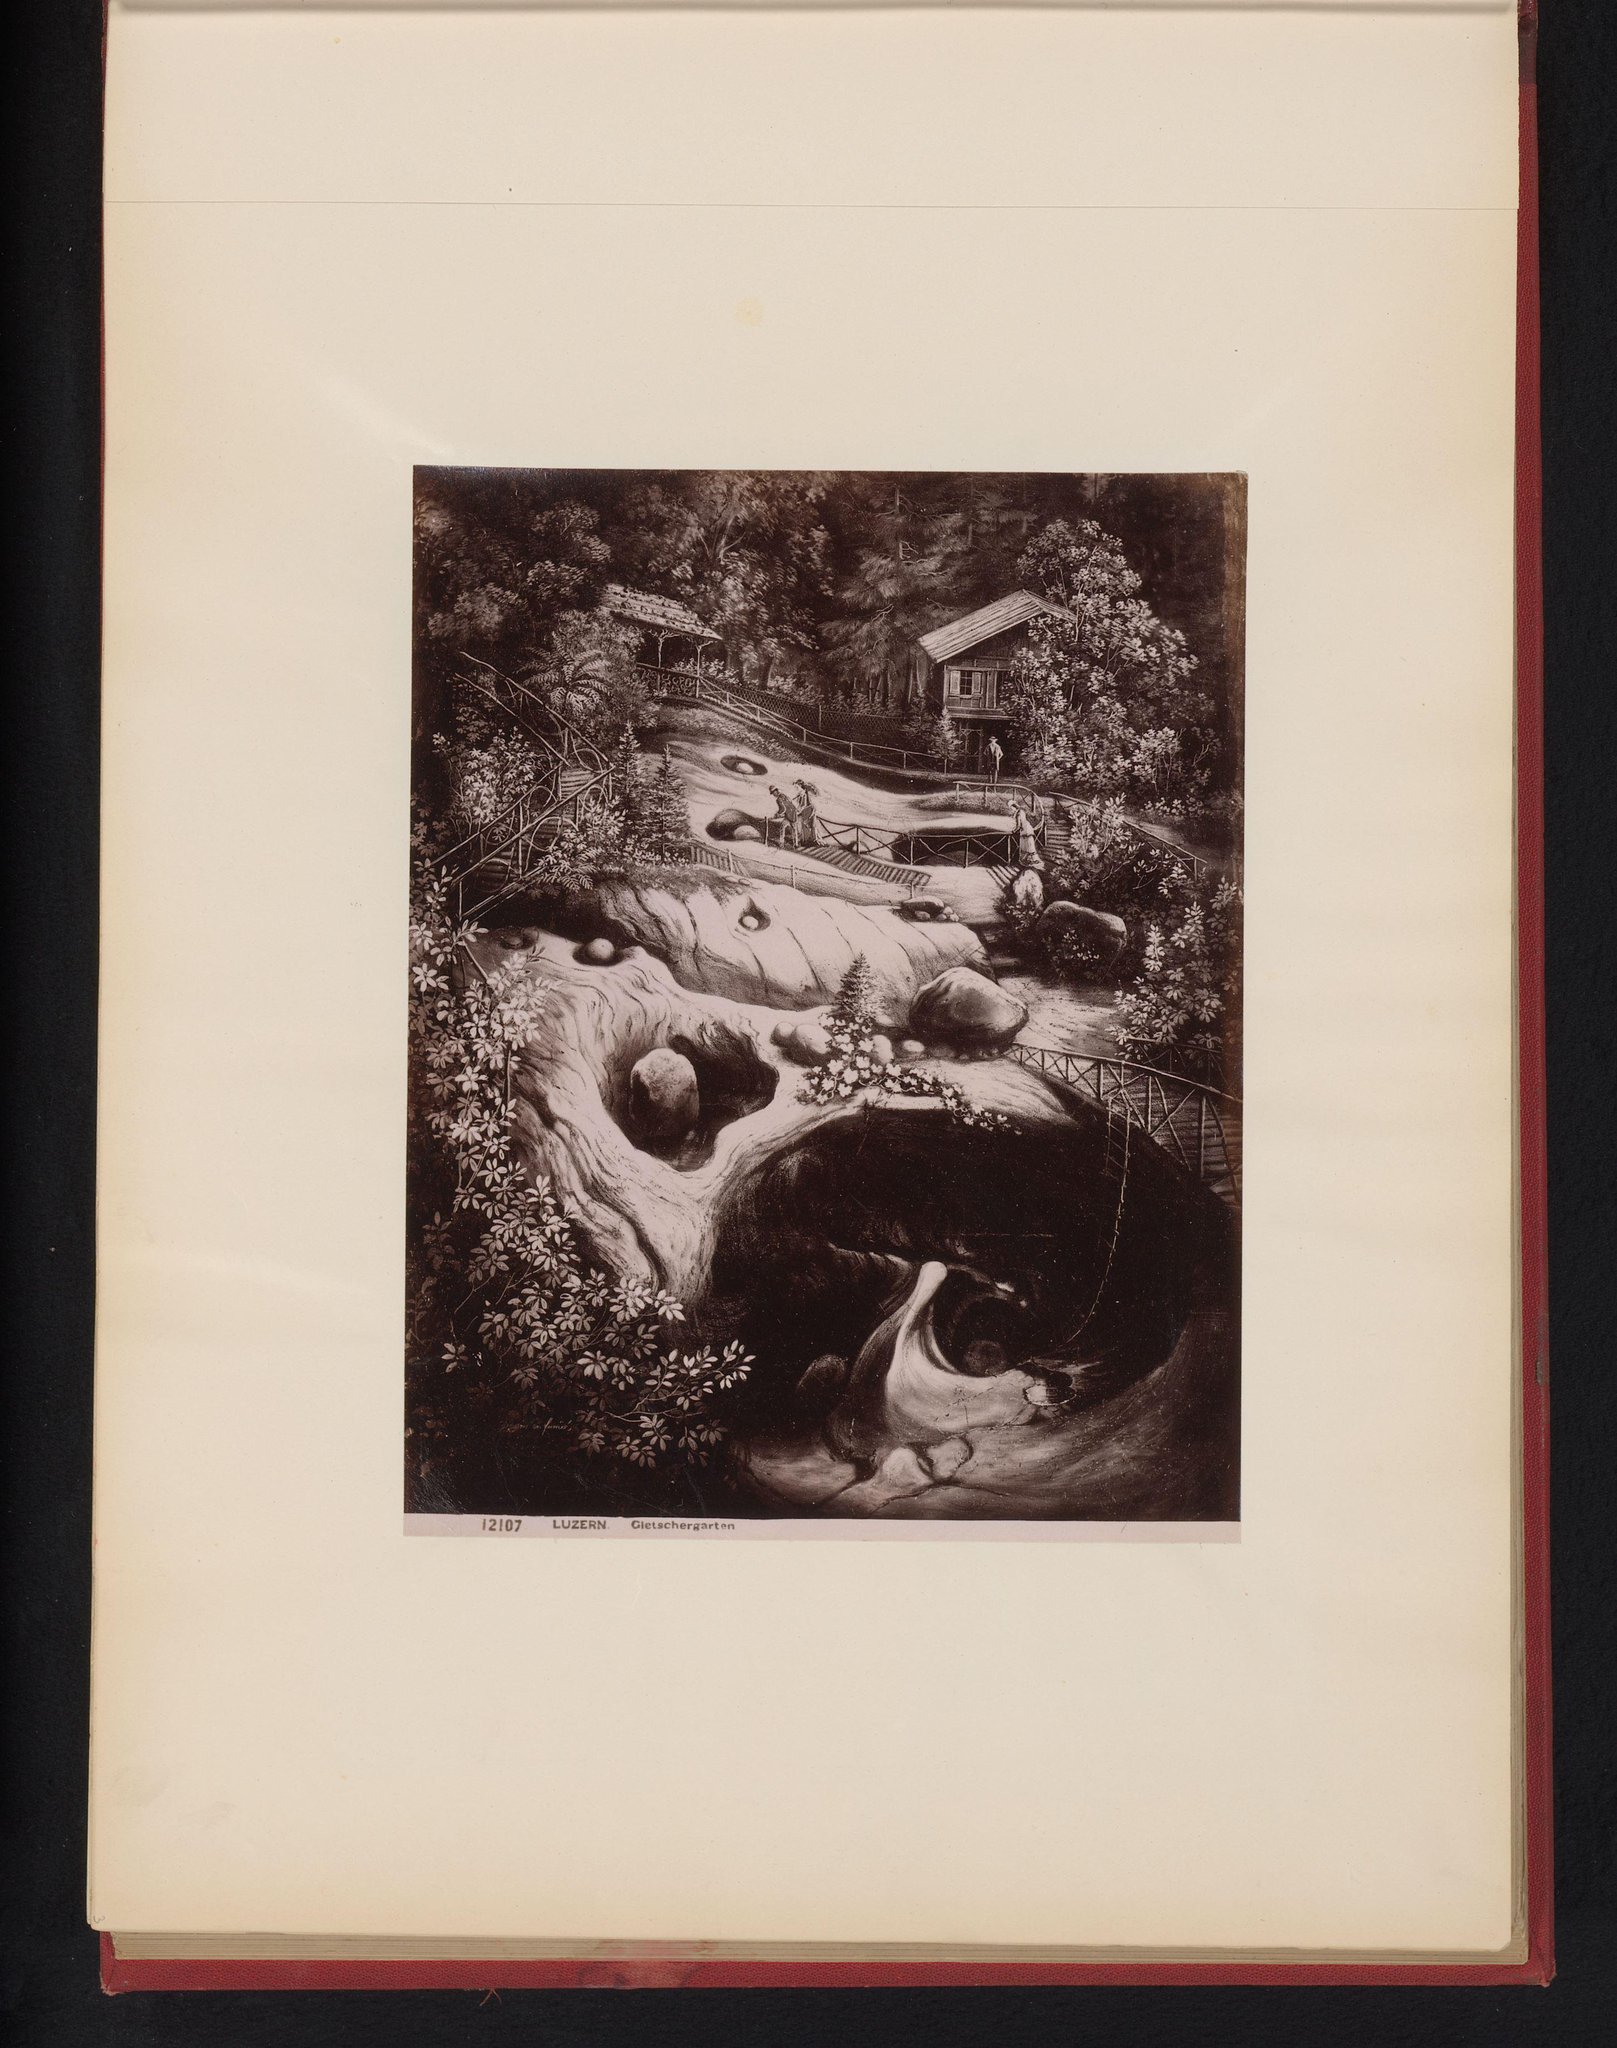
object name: photograph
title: Fotoreproductie van een tekening van een gezicht op de Gletschergarten te Luzern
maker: Anonymous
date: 1860-1900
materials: photographic support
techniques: albumen print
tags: garden, sculpture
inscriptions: inscription: ‘12107/ Luzern/ Gletschergarten’